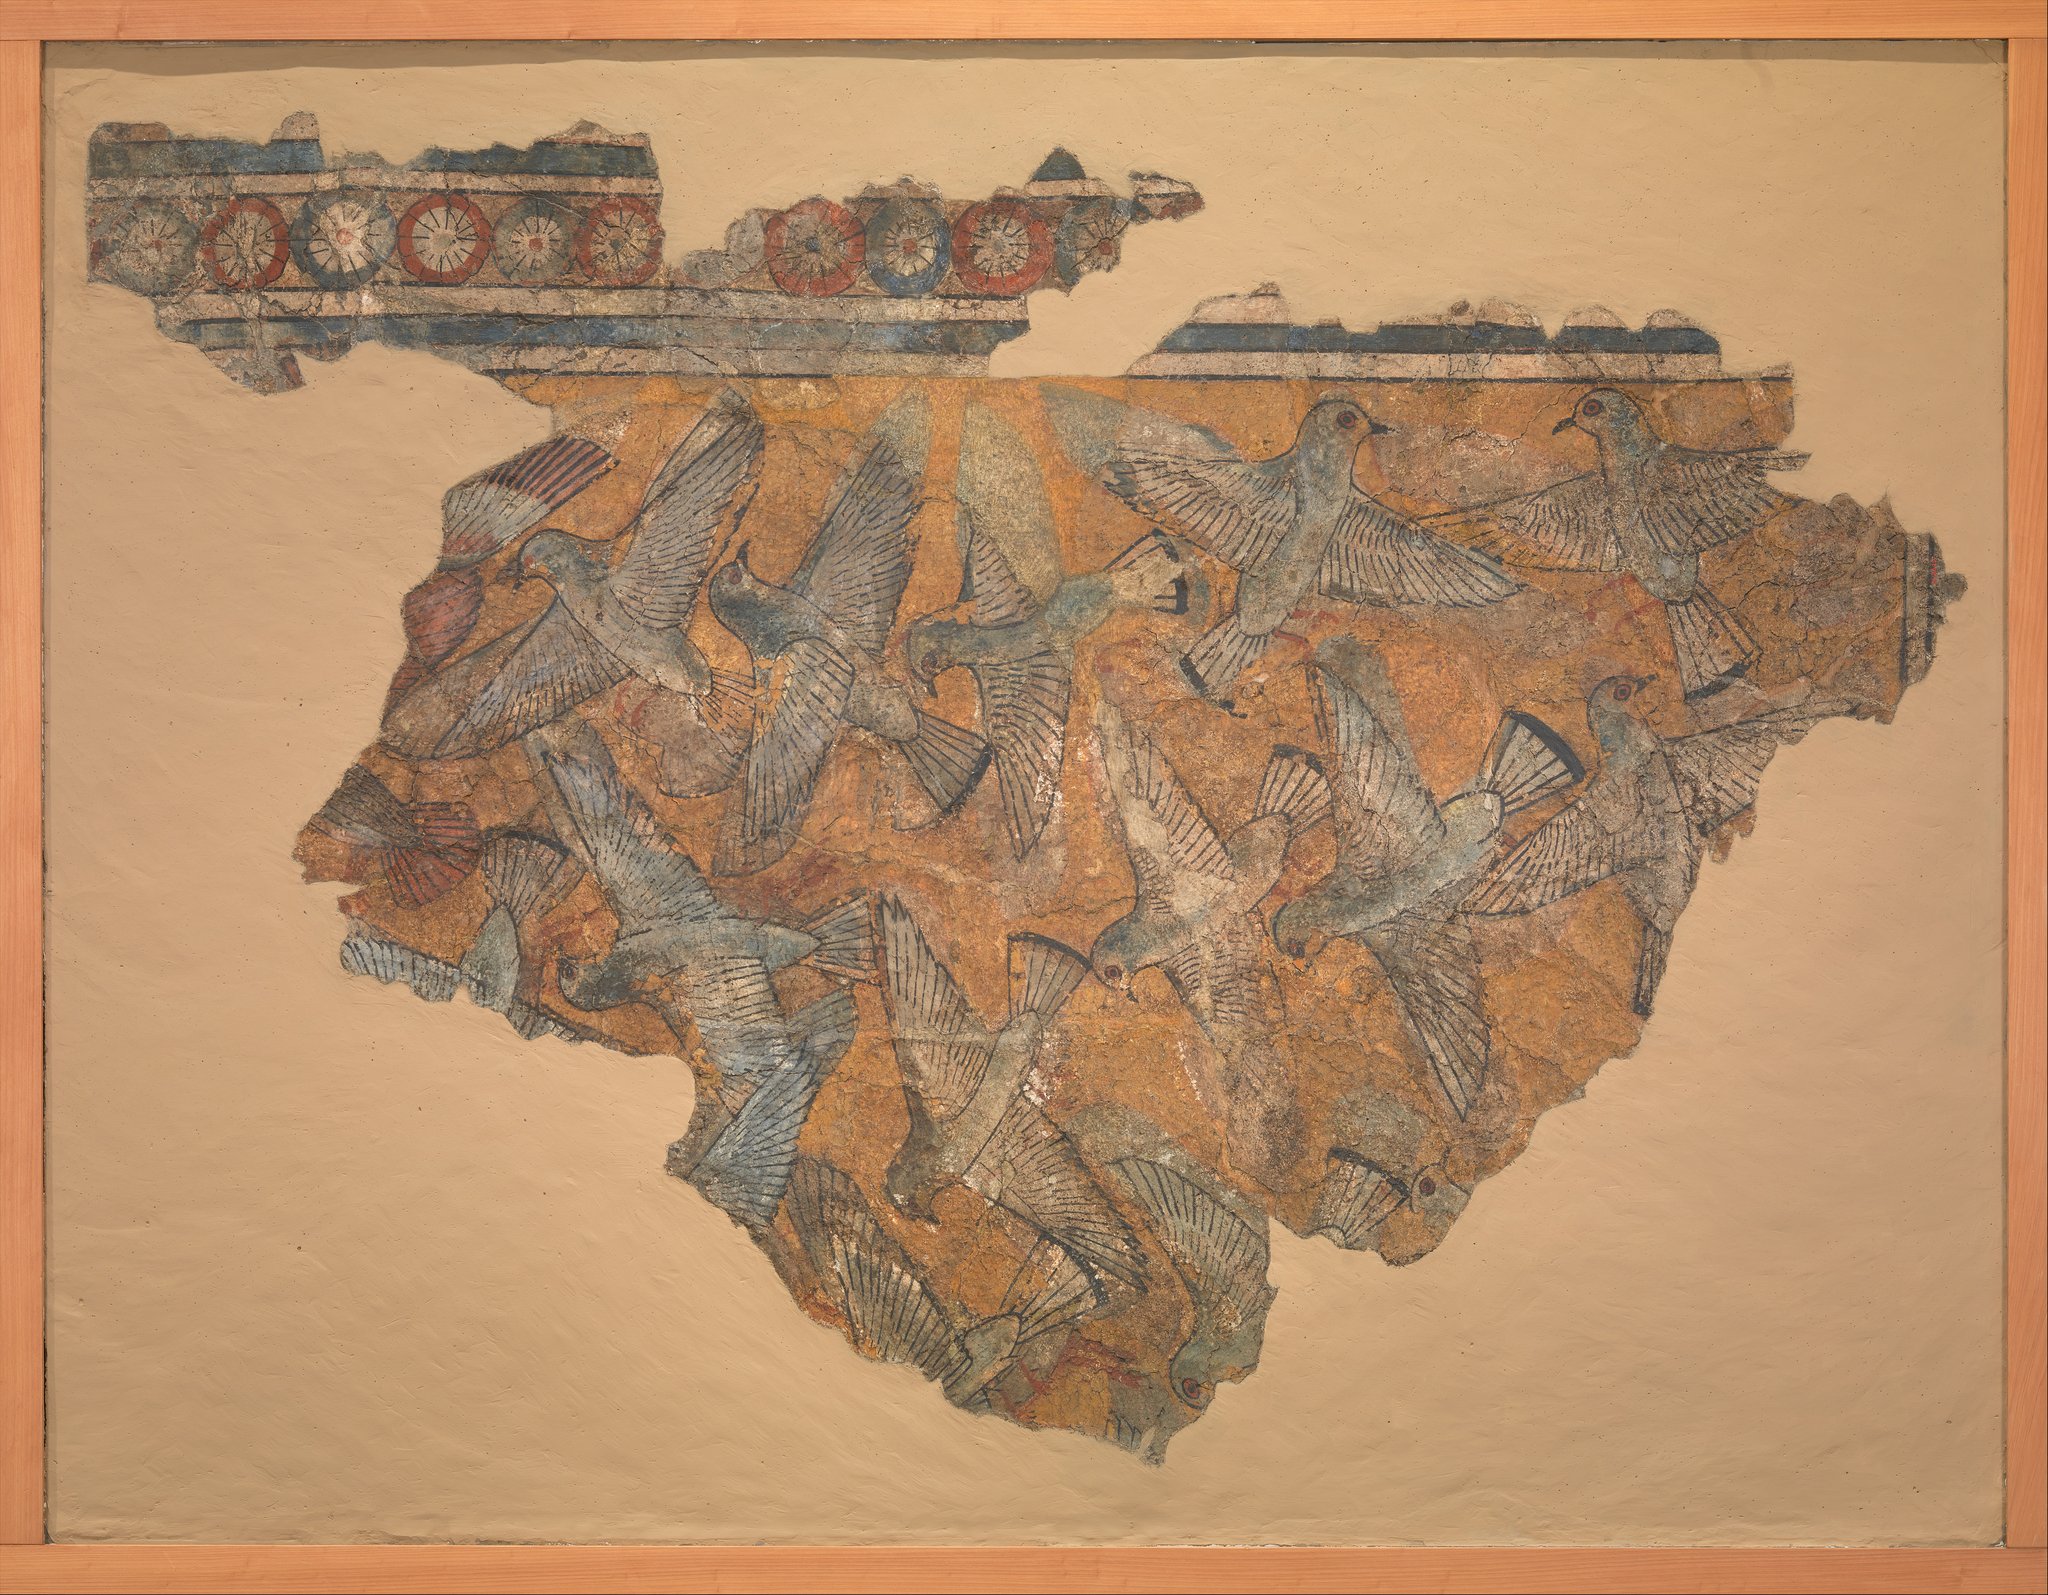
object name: ceiling painting, pigeon, malqata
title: Ceiling Fragment Depicting Pigeons in Flight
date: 1390-1352 BCE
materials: mud, paint, plaster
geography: egypt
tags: pigeons